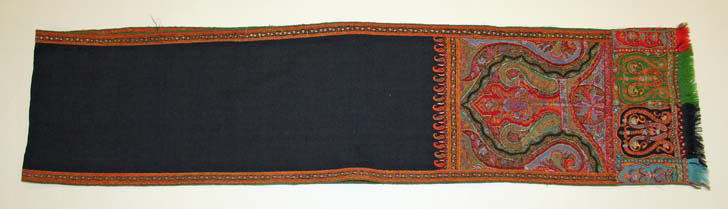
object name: scarf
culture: european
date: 1860-1865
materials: wool